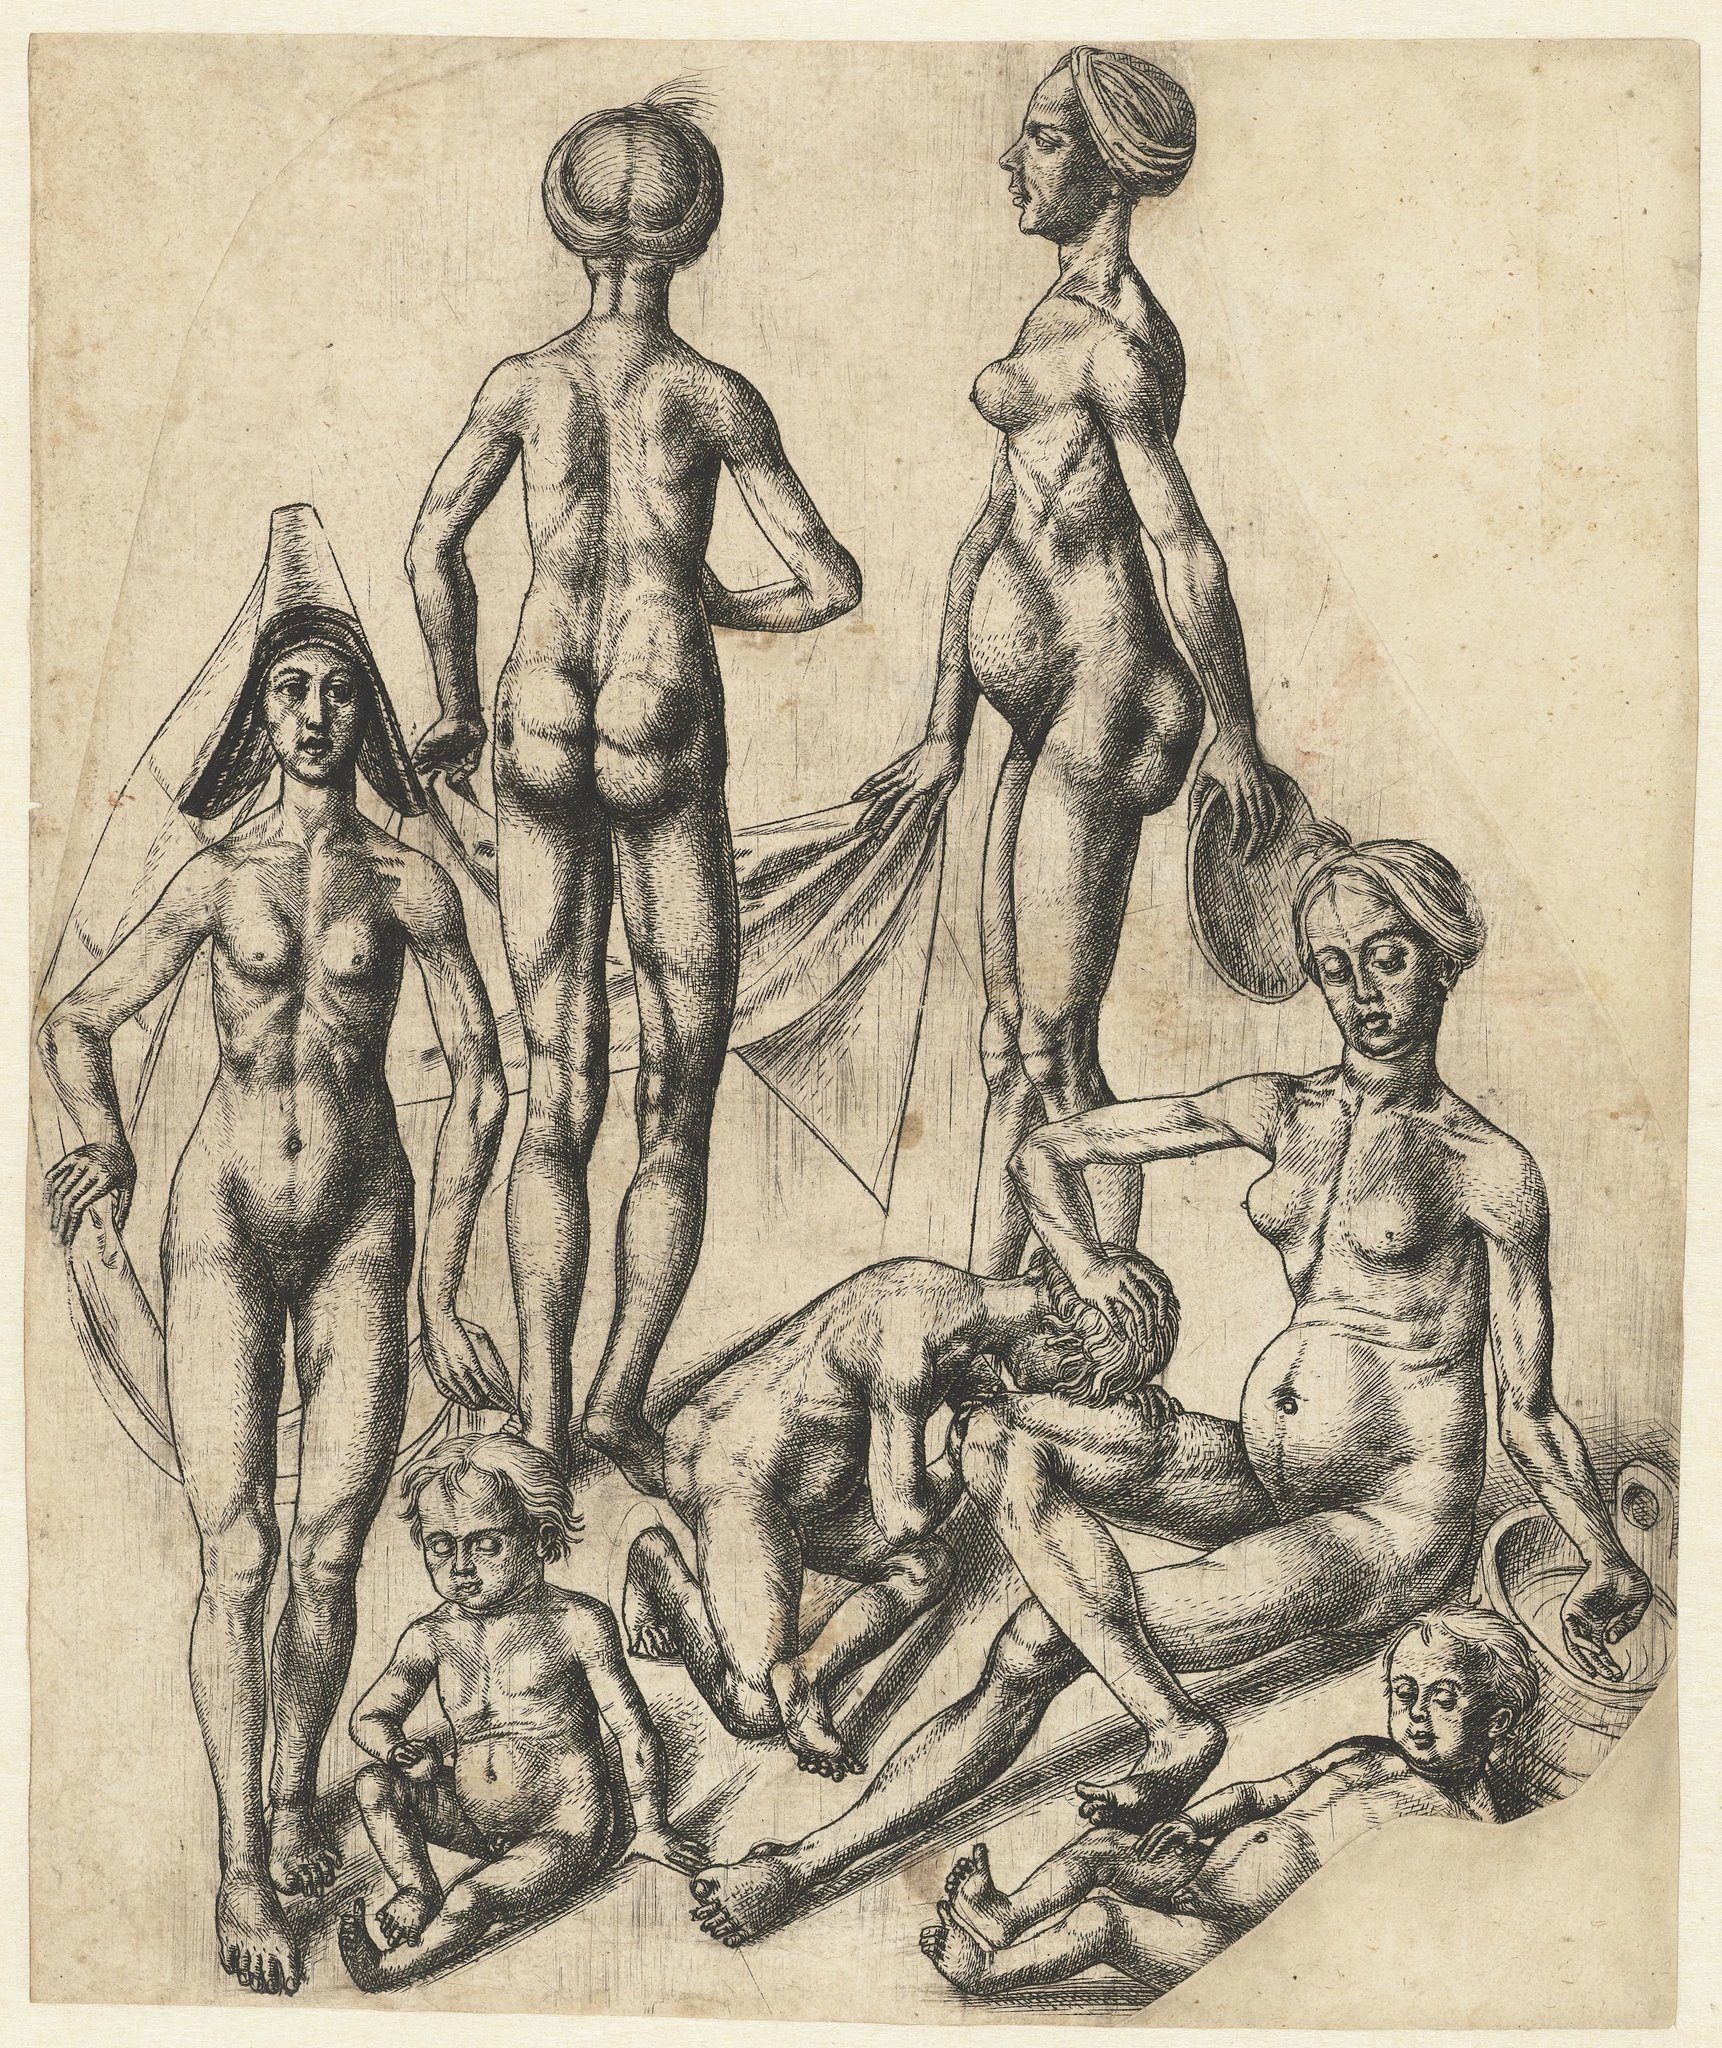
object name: print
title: Vrouwenbad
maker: monogrammist pm (15e eeuw)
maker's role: print maker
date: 1490-1500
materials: paper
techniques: engraving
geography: germany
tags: taking a bath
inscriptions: collector's mark: Lugt 2760, collector's mark: Lugt 2228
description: Drie staande vrouwen, een zittende vrouw en drie kinderen, badend en allen naakt.